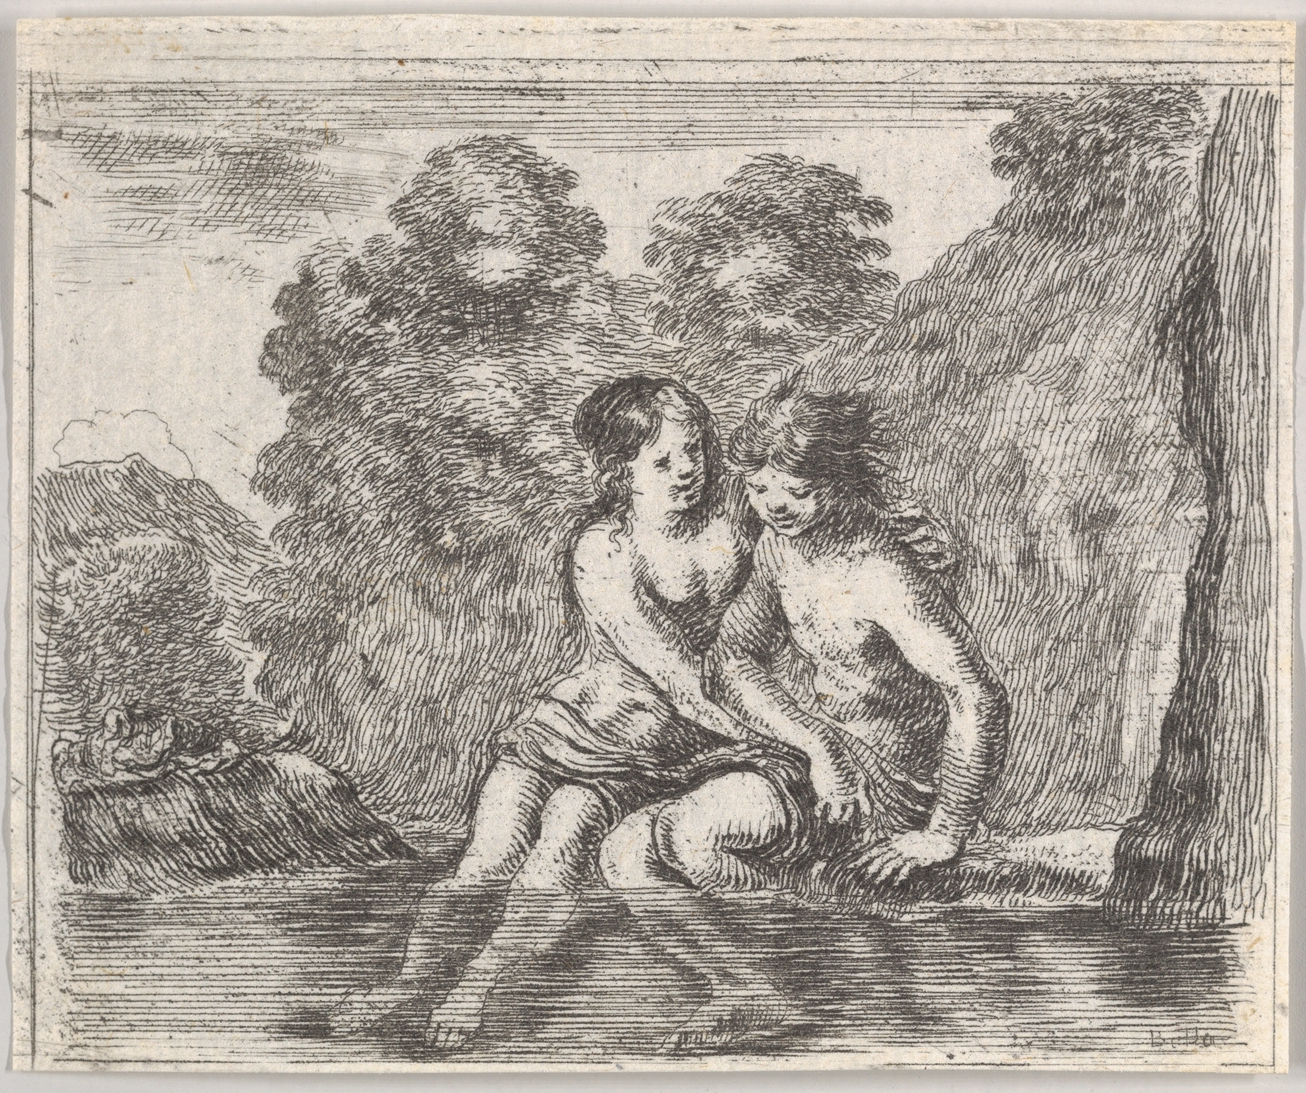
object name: print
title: Salmacis and Hermaphrodite, from "Game of Mythology" (Jeu de la Mythologie)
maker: stefano della bella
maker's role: artist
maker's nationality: italian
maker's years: 1610-1664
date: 1644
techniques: etching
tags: hermaphrodites,nymphs